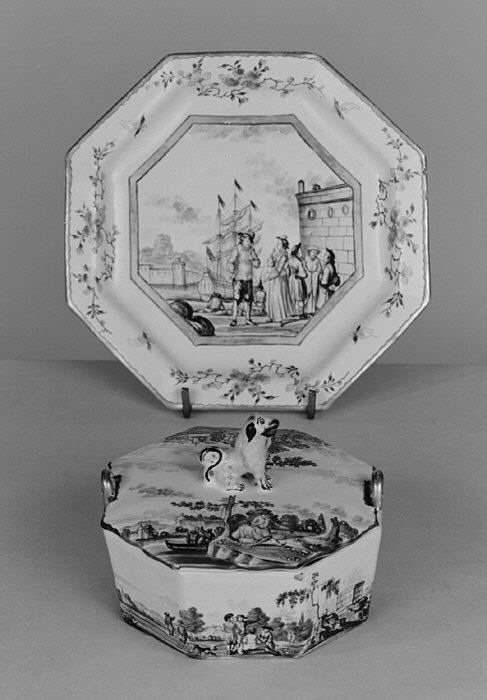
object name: butter dish with cover and stand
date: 1750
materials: faience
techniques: glazing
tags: men,women,dogs,landscapes